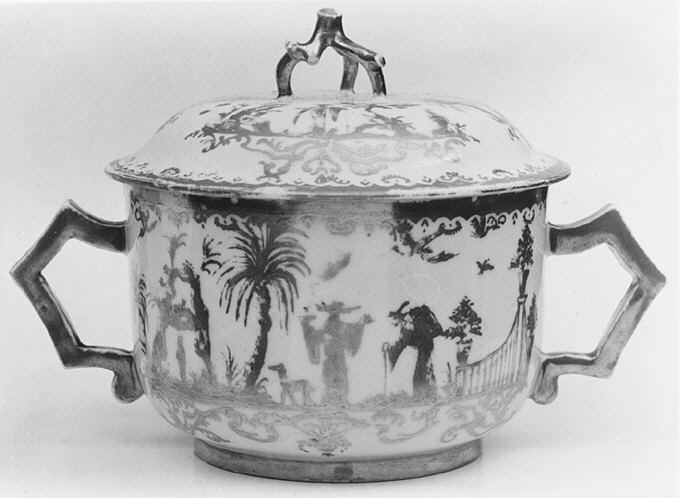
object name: sugar bowl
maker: meissen manufactory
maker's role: manufactory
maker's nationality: german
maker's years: 1710-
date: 1701-1800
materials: hard paste porcelain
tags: human figures,dogs